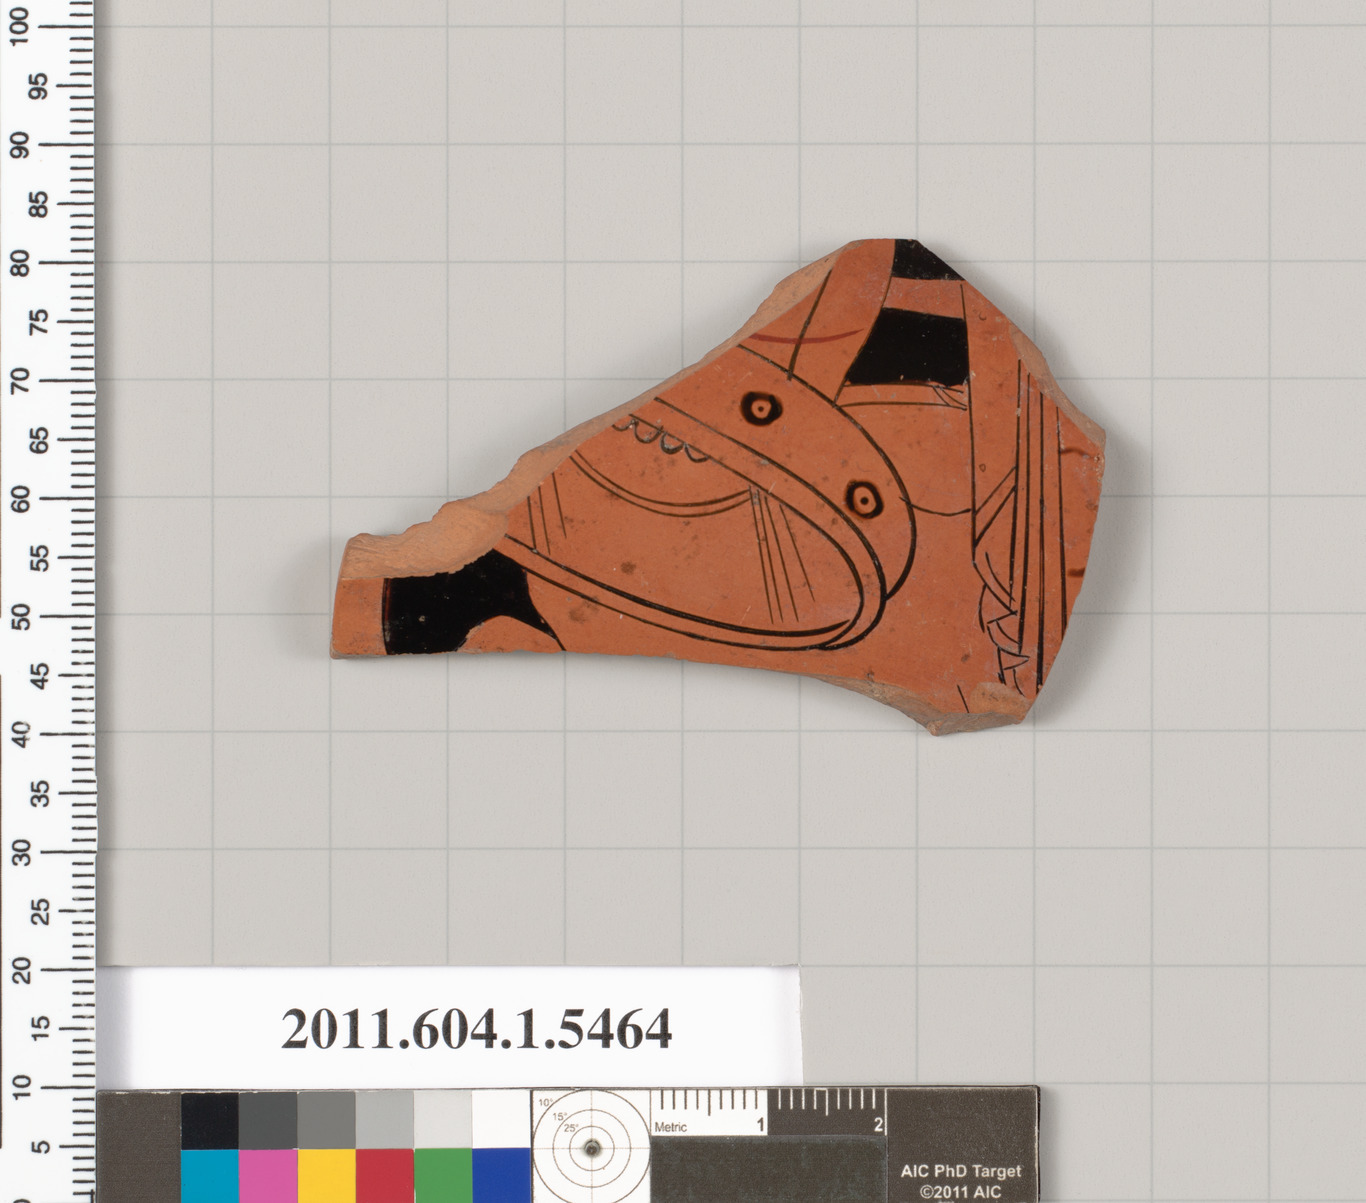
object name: kylix fragment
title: Terracotta fragment of a kylix (drinking cup)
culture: greek, attic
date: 510-500 BCE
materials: terracotta